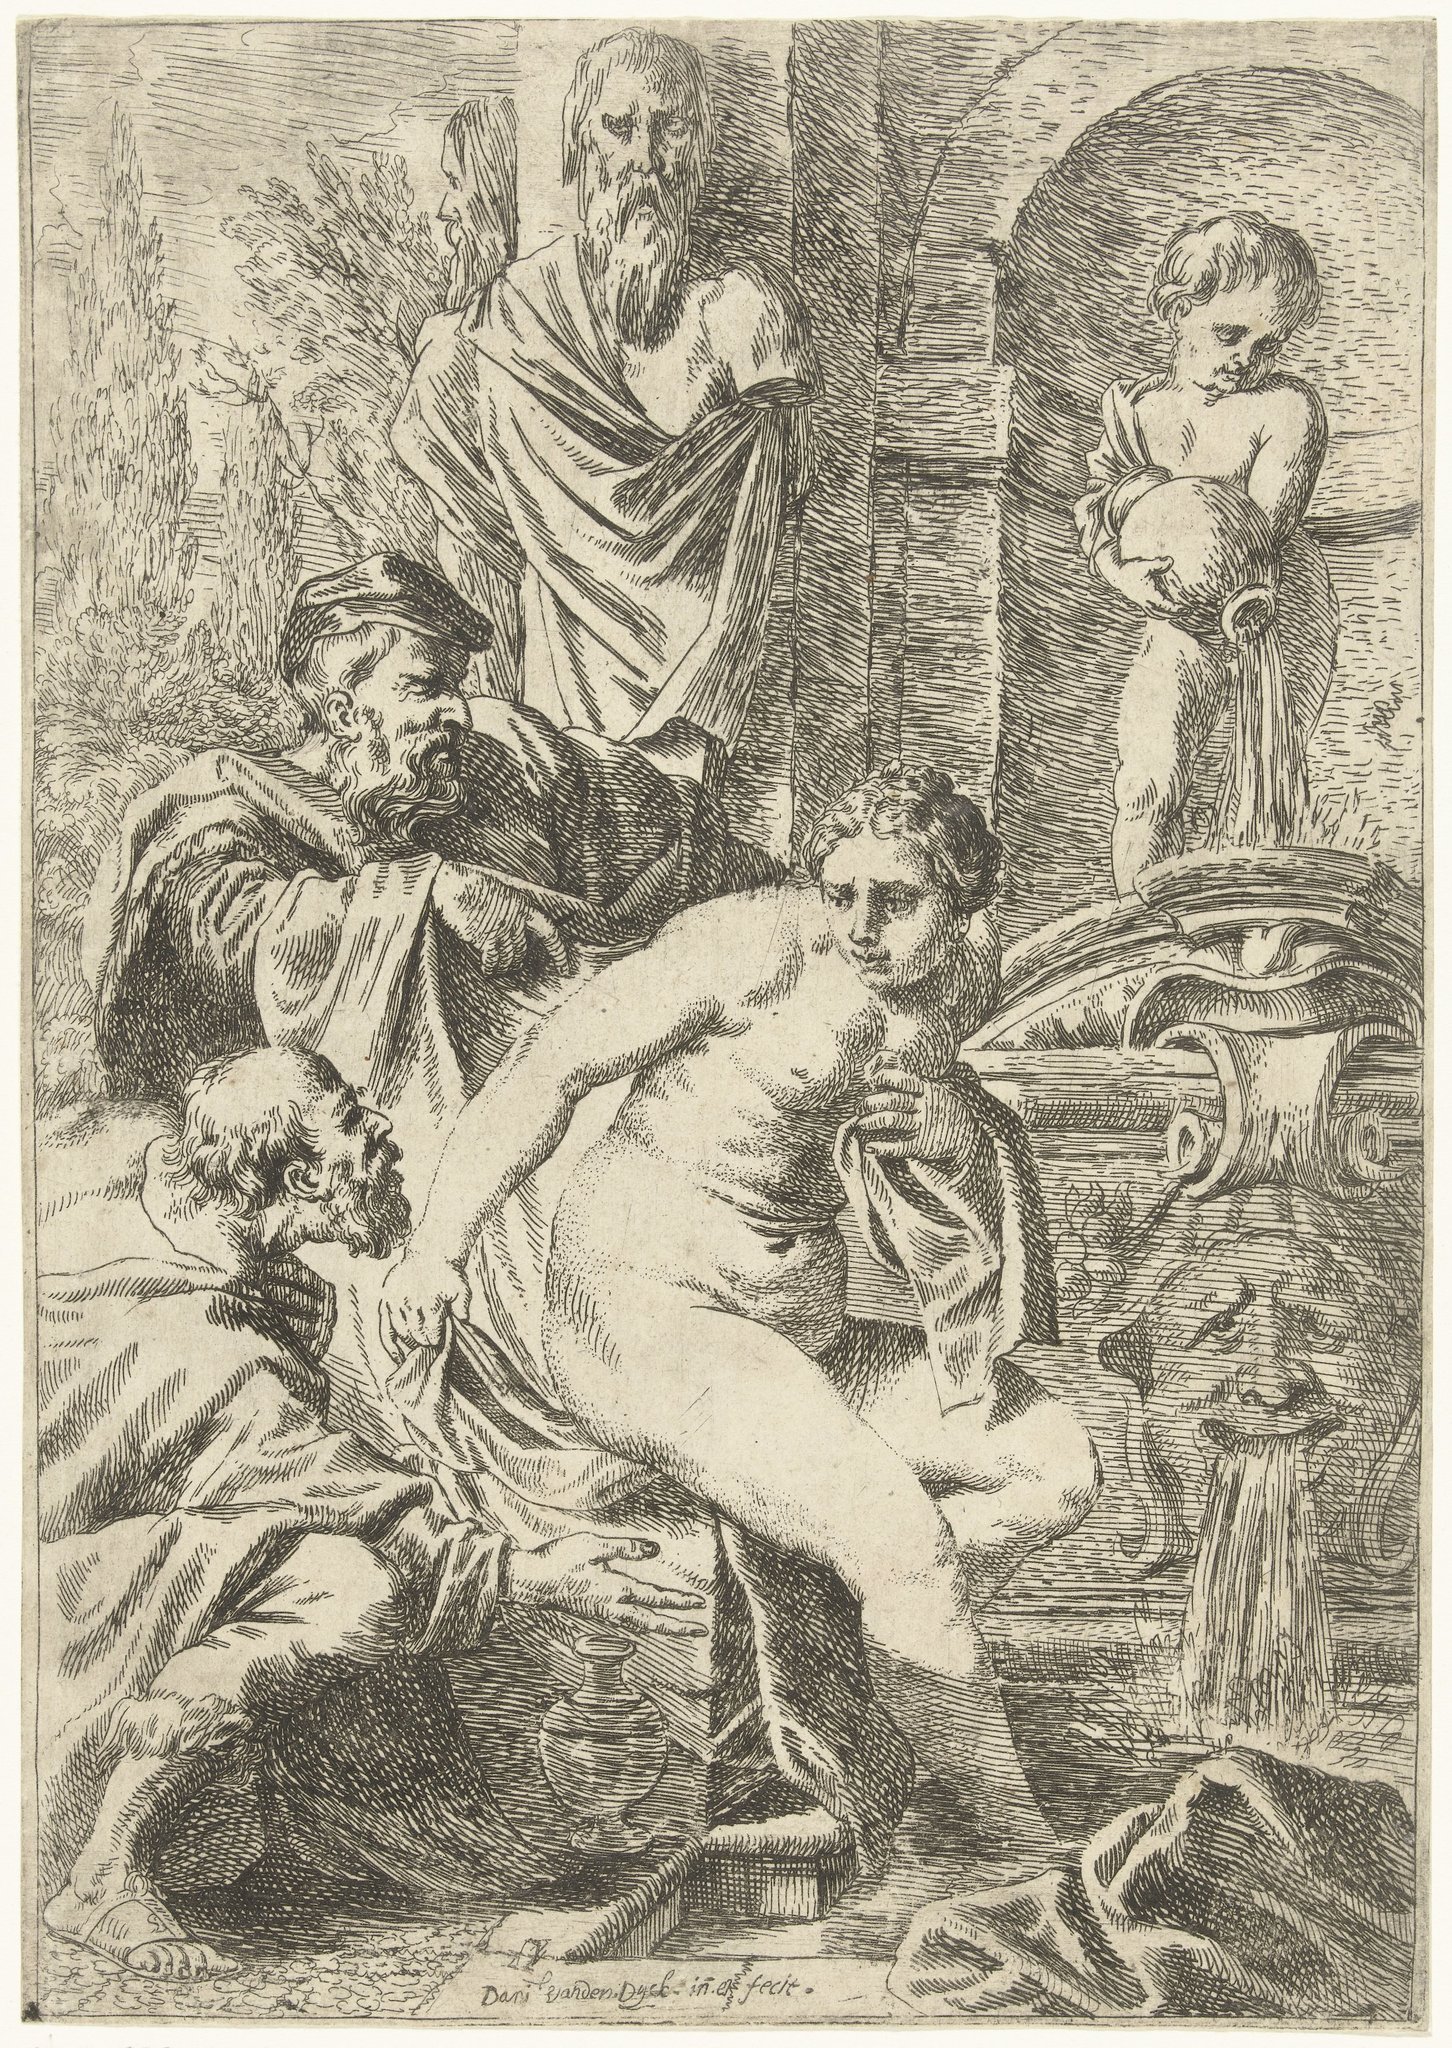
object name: print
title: Susanna en de ouderlingen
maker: daniël van den dyck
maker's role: draughtsman, painter, print maker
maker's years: 1614-1663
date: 1635-1670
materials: paper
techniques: etching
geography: italy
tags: the story of susanna and the elders (in which the youth daniel intervenes on behalf of susanna) (daniel 13)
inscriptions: collector's mark: Lugt 2228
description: Susanna zit in de tuin bij een fontein en wordt belaagt door twee ouderlingen die haar willen verleiden. Susanna is half naakt, een ouderling trekt haar omslagdoek op zij.